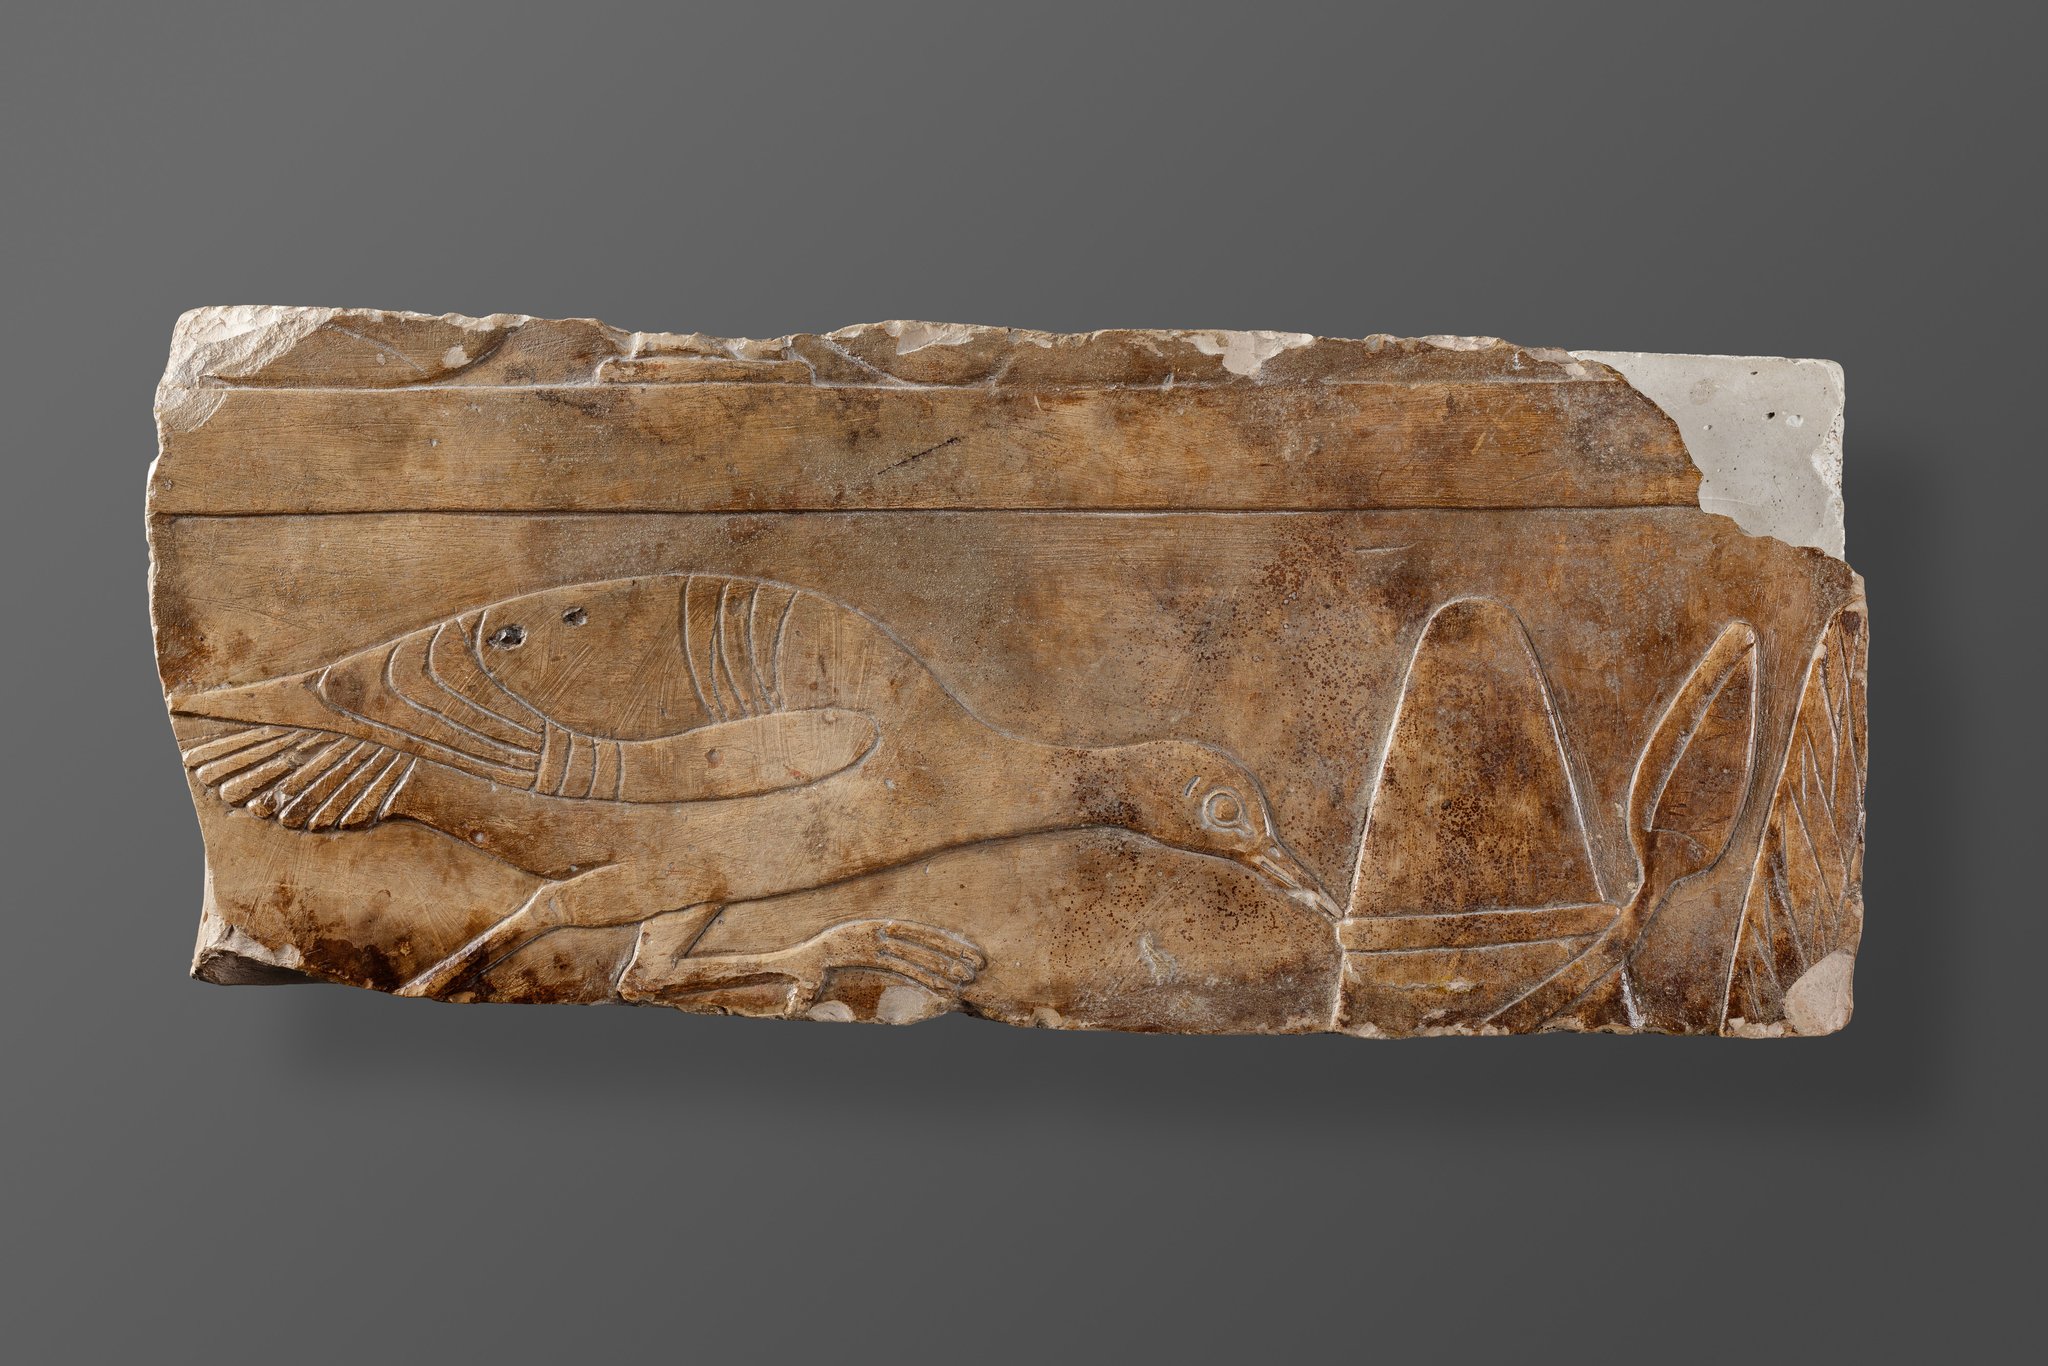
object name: relief, tomb of nespekashuty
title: Raised relief fragment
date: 664-610 BCE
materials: limestone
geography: egypt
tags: birds